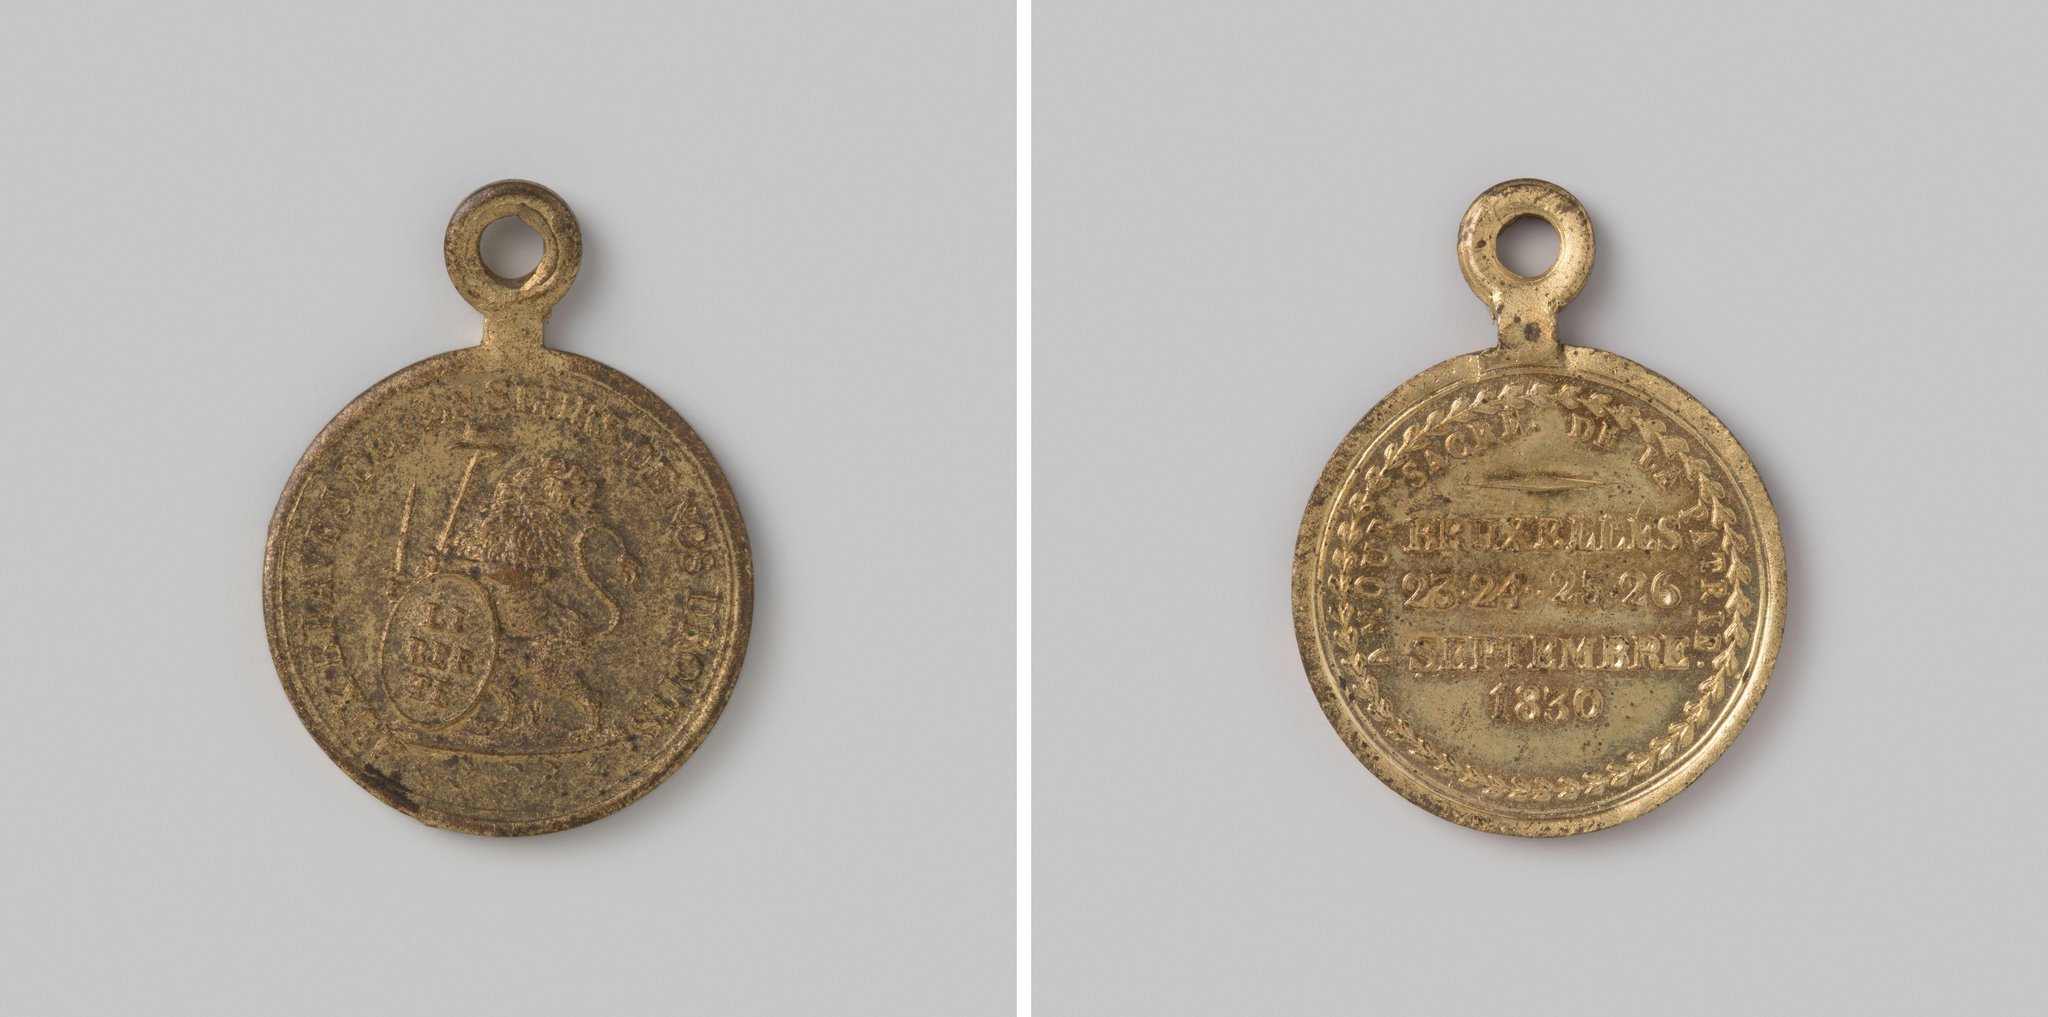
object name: insignia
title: Septemberdagen te Brussel, ter ere van degenen die voor de onafhankelijkheid van het vaderland hebben gevochten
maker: Anonymous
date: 1830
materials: copper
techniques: striking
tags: belgium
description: Koperen draagteken aan draagoog. Voorzijde: leeuw met vrijheidshoed op speer, zwaard en wapenschild binnen omschrift. Keerzijde: opschrift binnen lauwerkrans